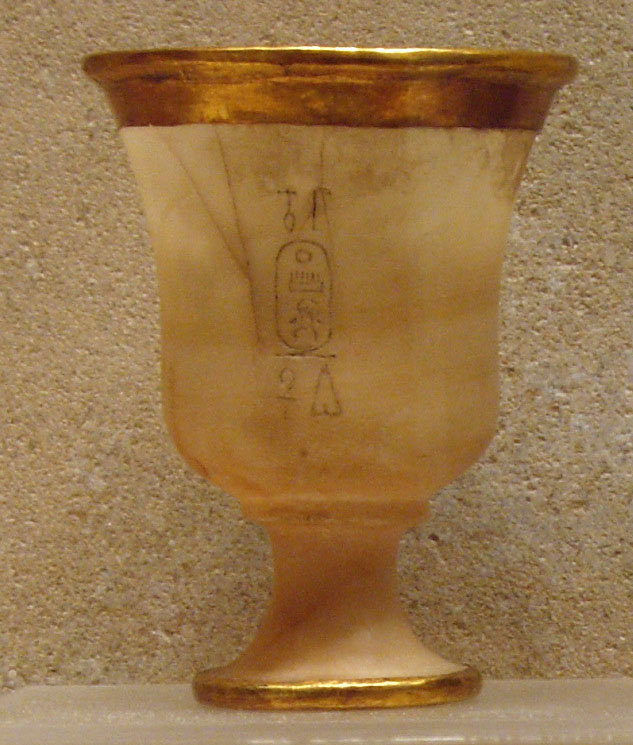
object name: chalice, cup, lotiform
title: Goblet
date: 1479-1425 BCE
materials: gold, stone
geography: egypt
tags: hieroglyphs